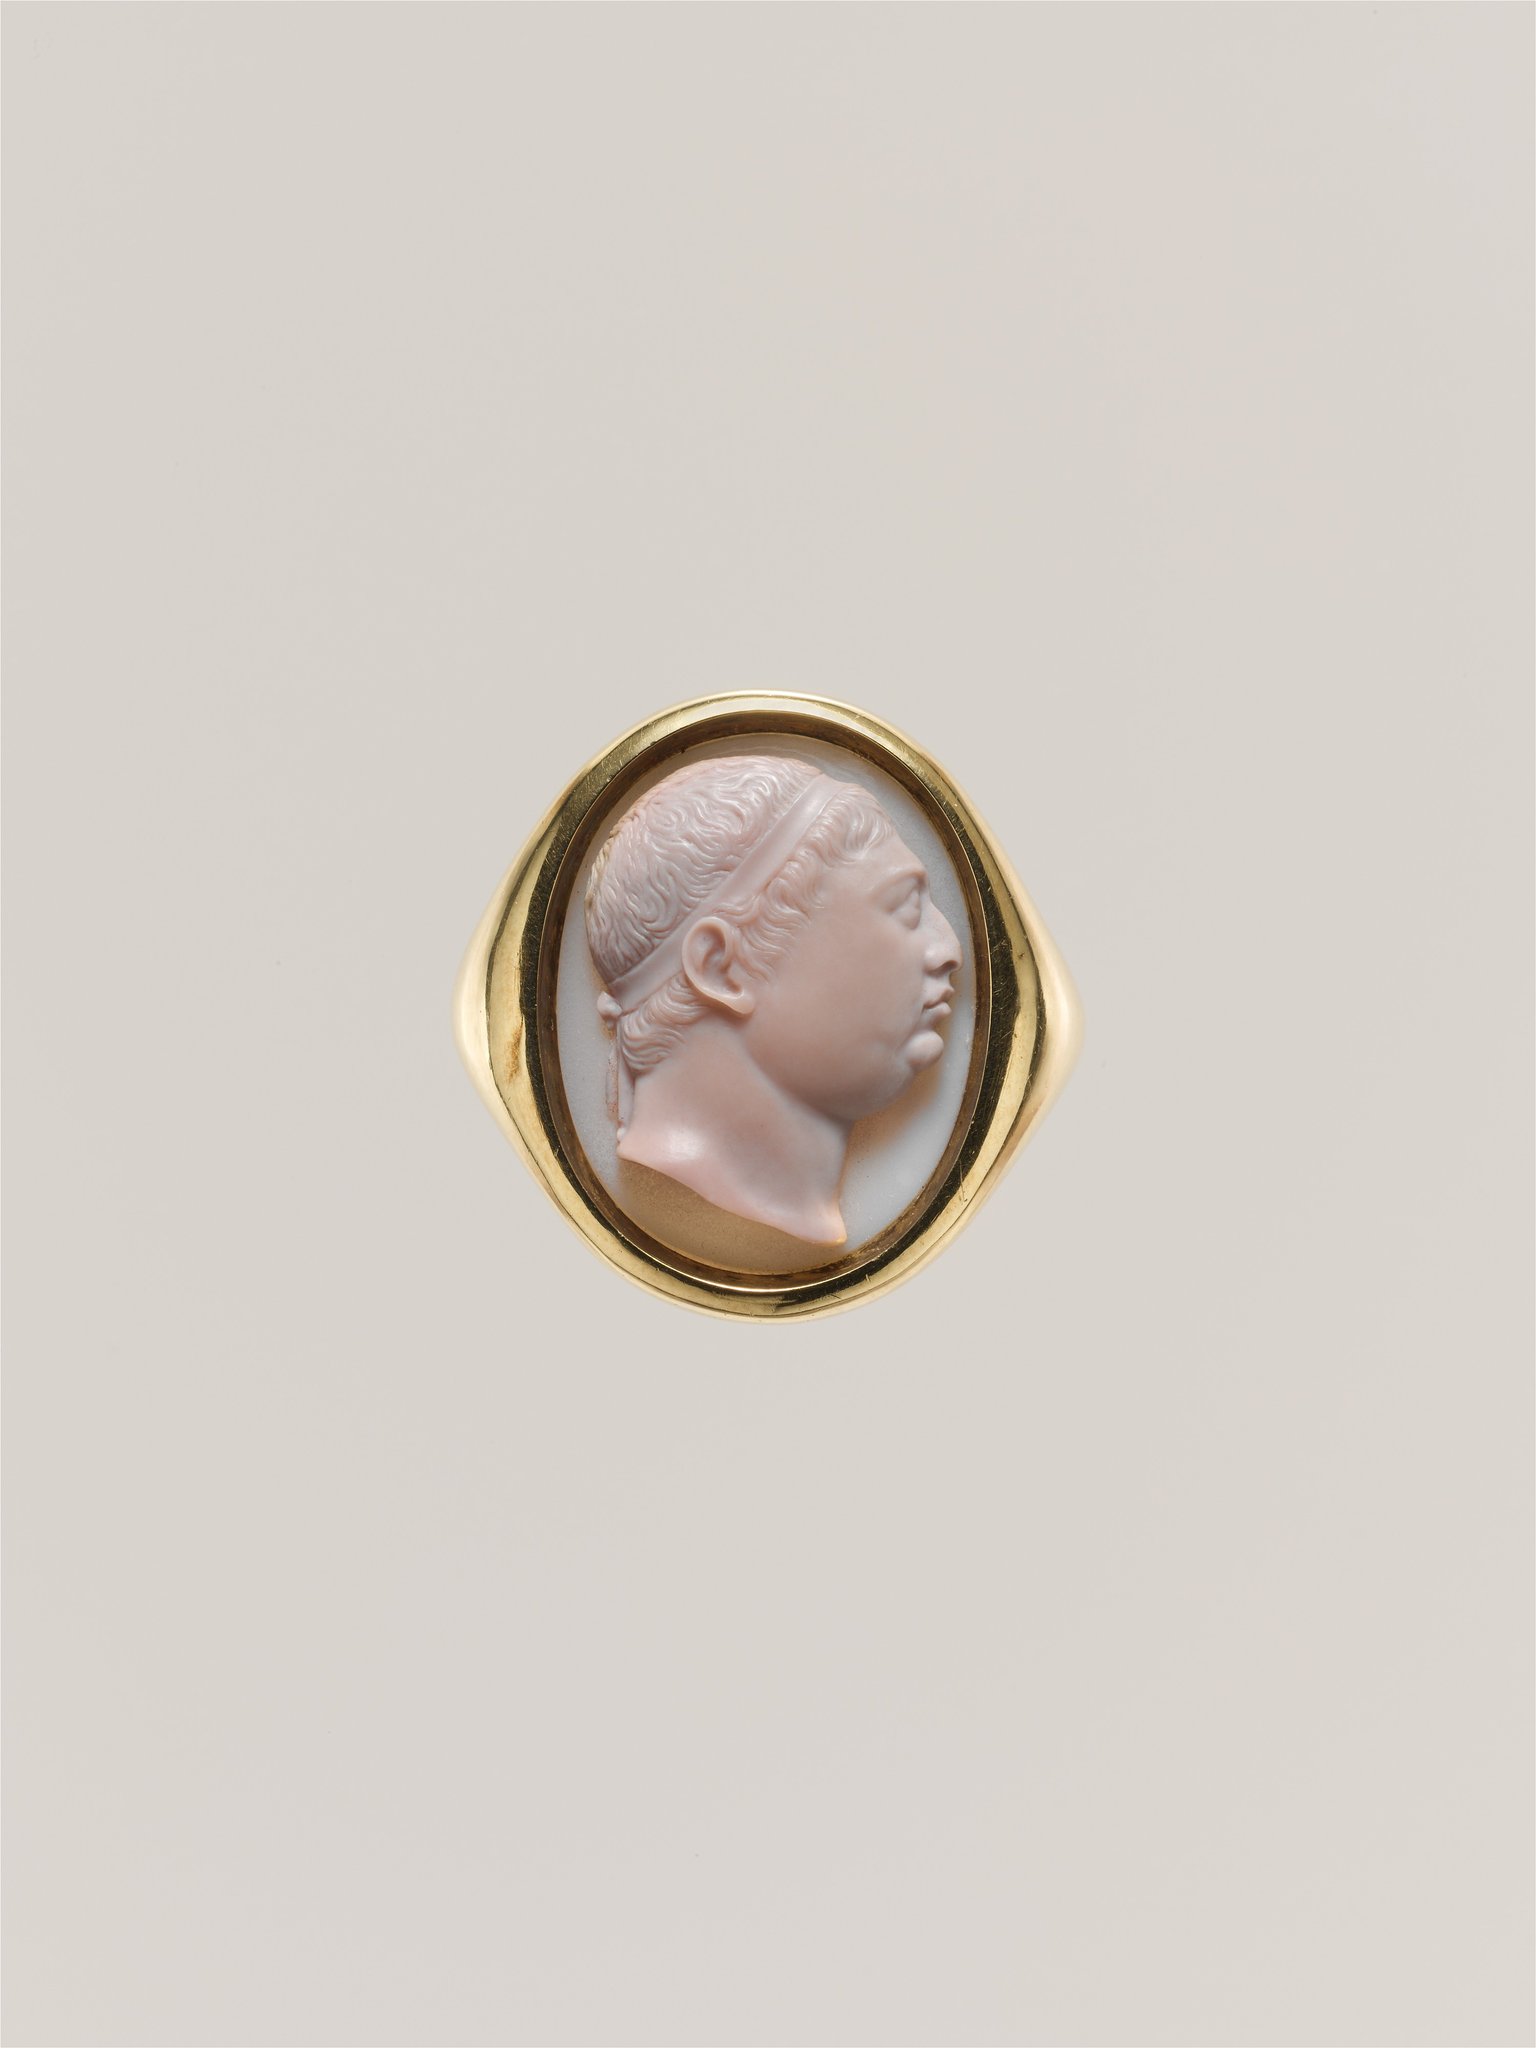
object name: cameo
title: George III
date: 1820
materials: gold, onyx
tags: men,profiles